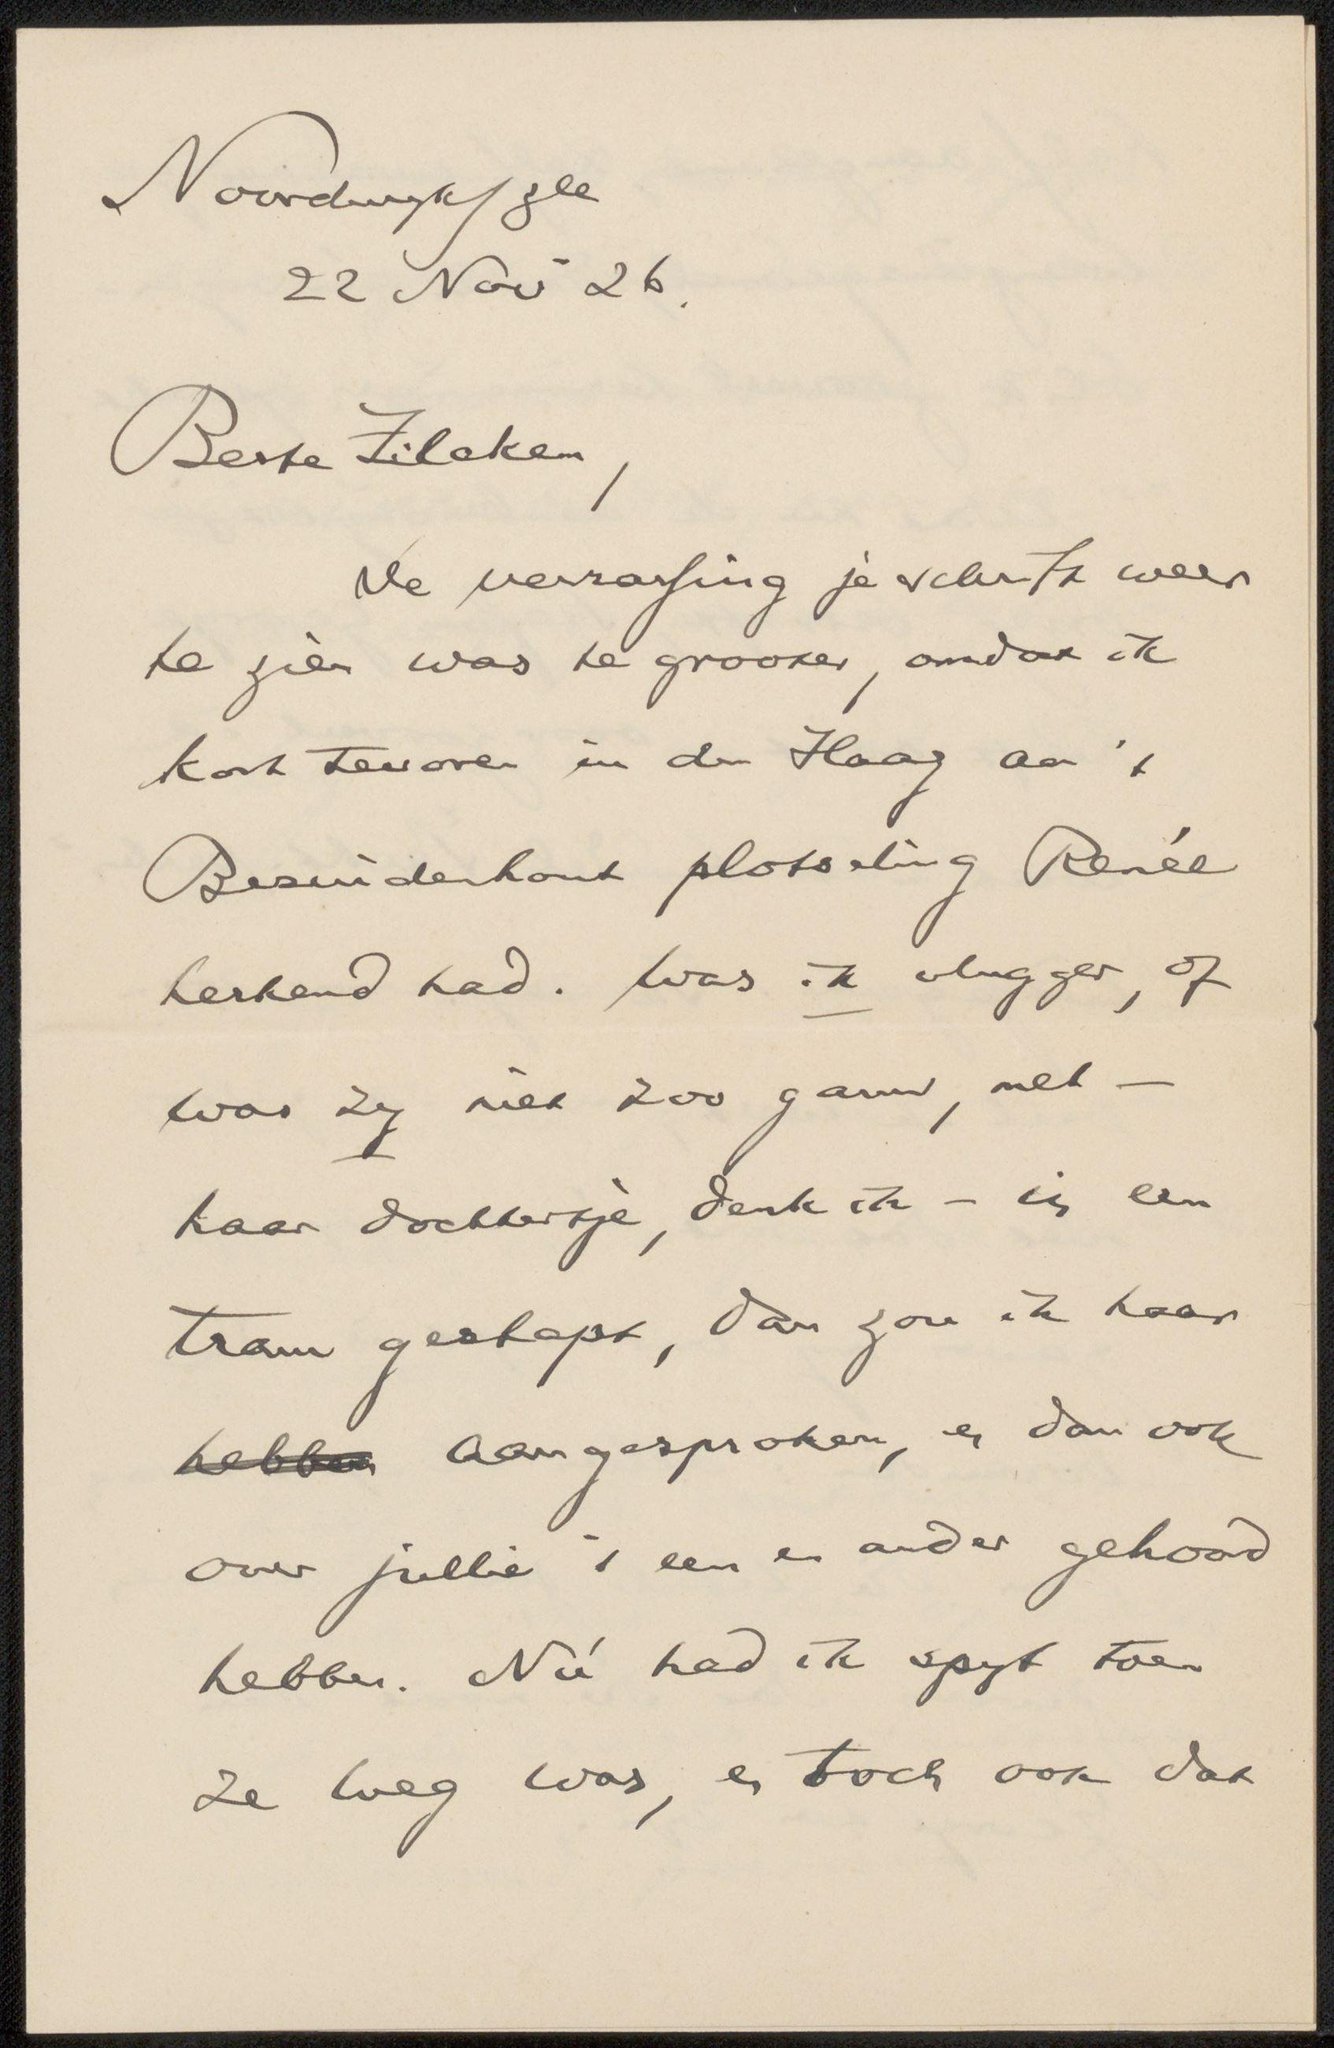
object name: letter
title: Brief aan Philip Zilcken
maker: albert verwey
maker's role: criticus, dichter, essayist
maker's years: 1865-1937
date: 1926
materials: ink, paper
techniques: pen, writing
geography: noordwijk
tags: voorburg, renée hélène laure zilcken, stefan george, painter, draughtsman, philip zilcken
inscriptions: collector's mark: ‘RPK’